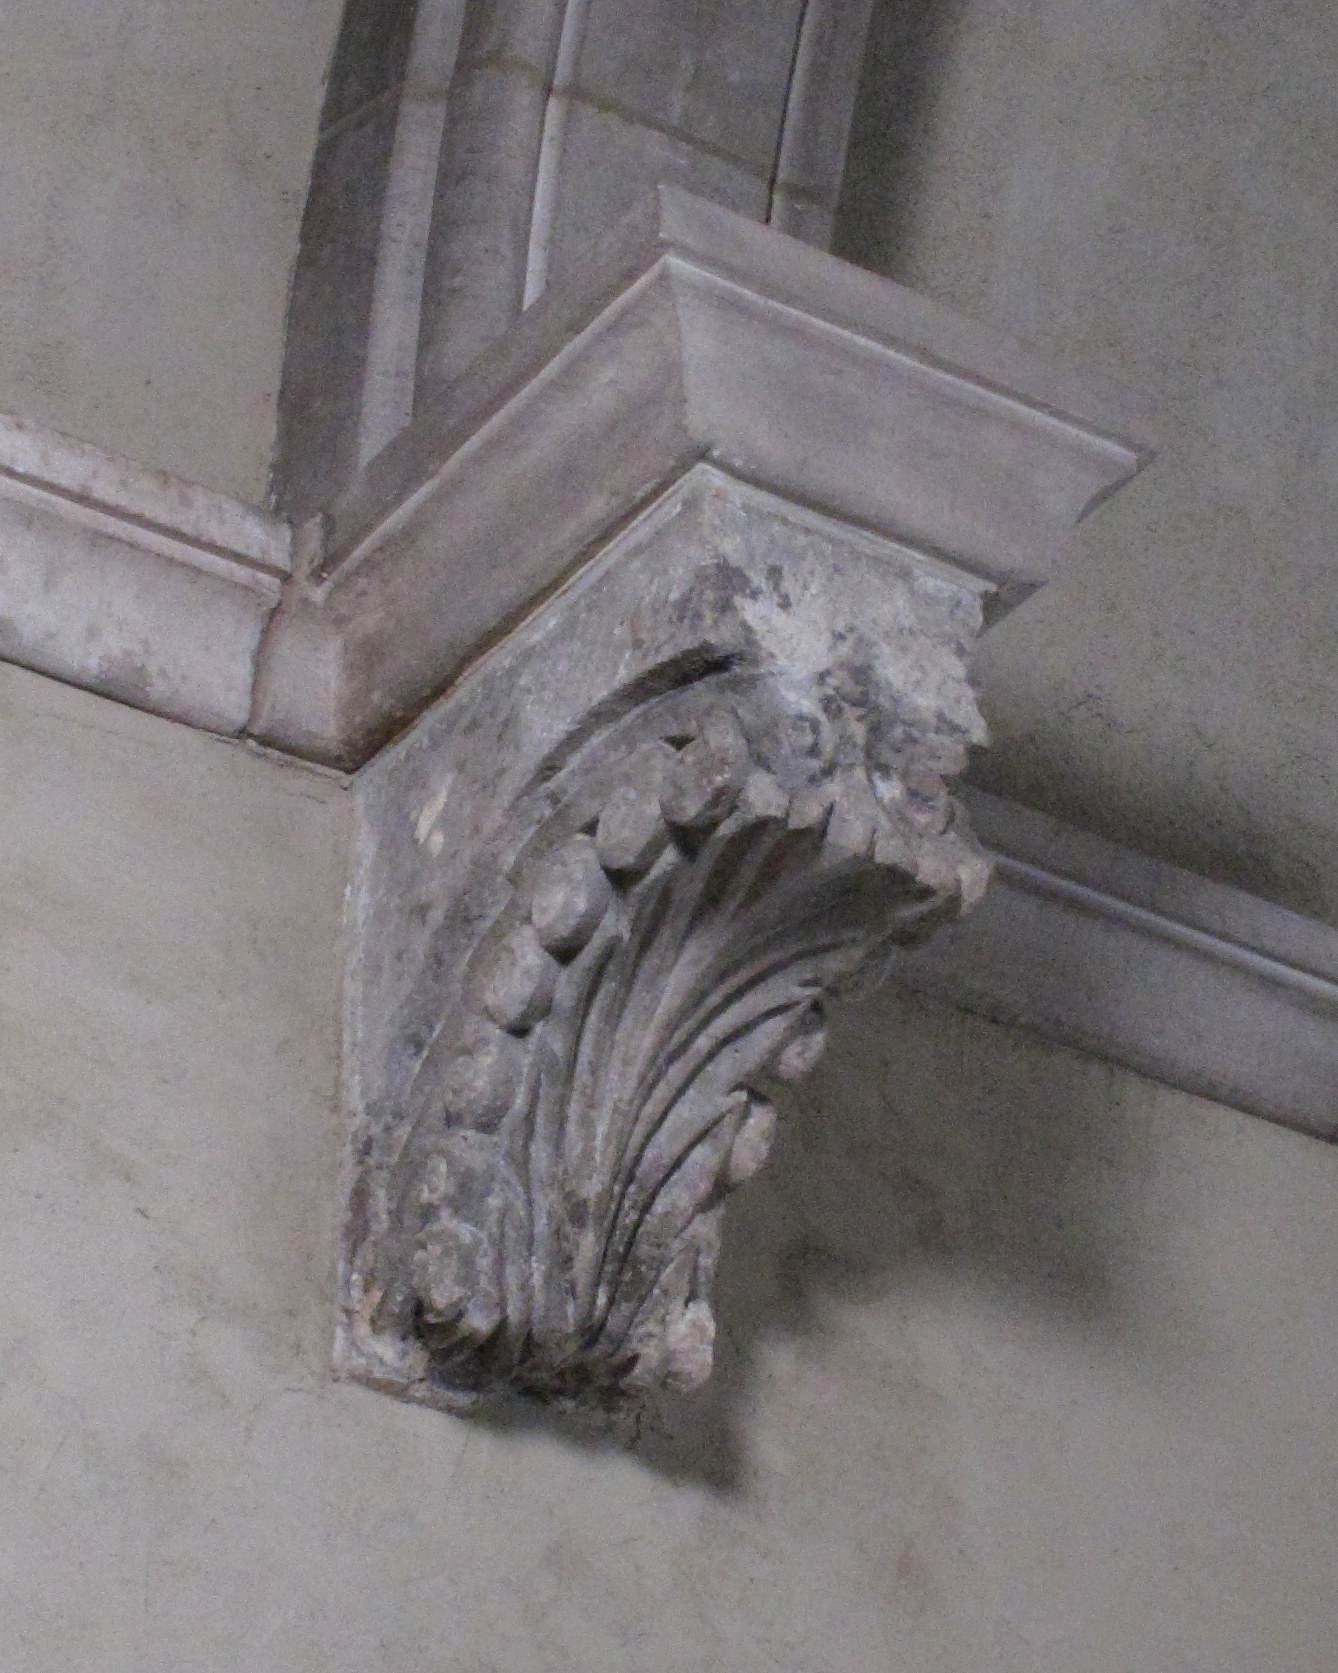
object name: corbel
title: Foliate Corbel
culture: french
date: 1150-1200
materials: limestone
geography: france